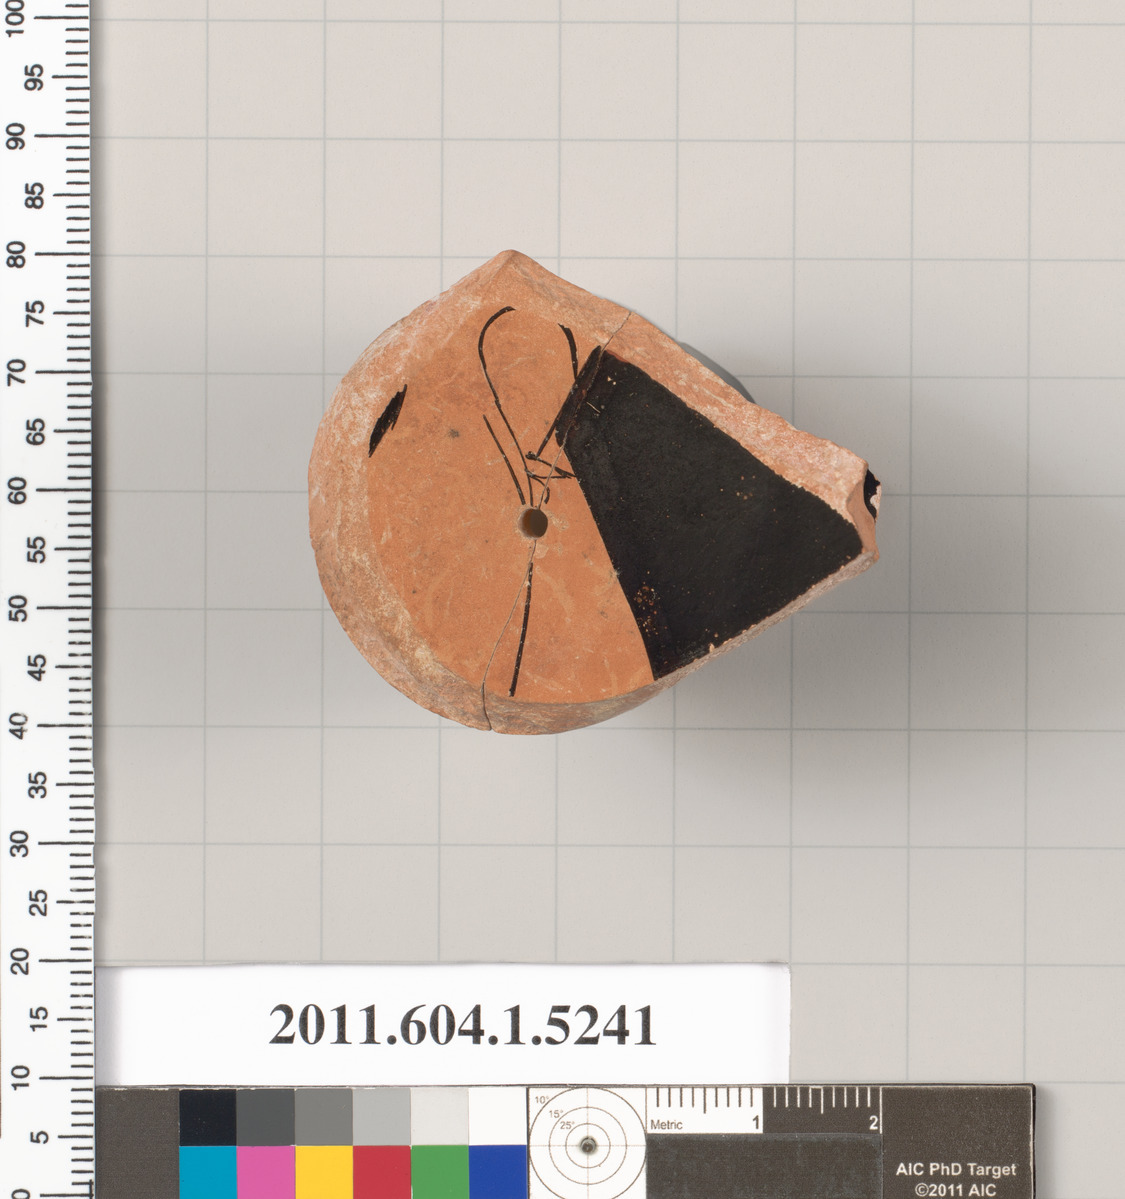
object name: kylix fragment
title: Terracotta fragment of a kylix (drinking cup)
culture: greek, attic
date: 520-500 BCE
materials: terracotta